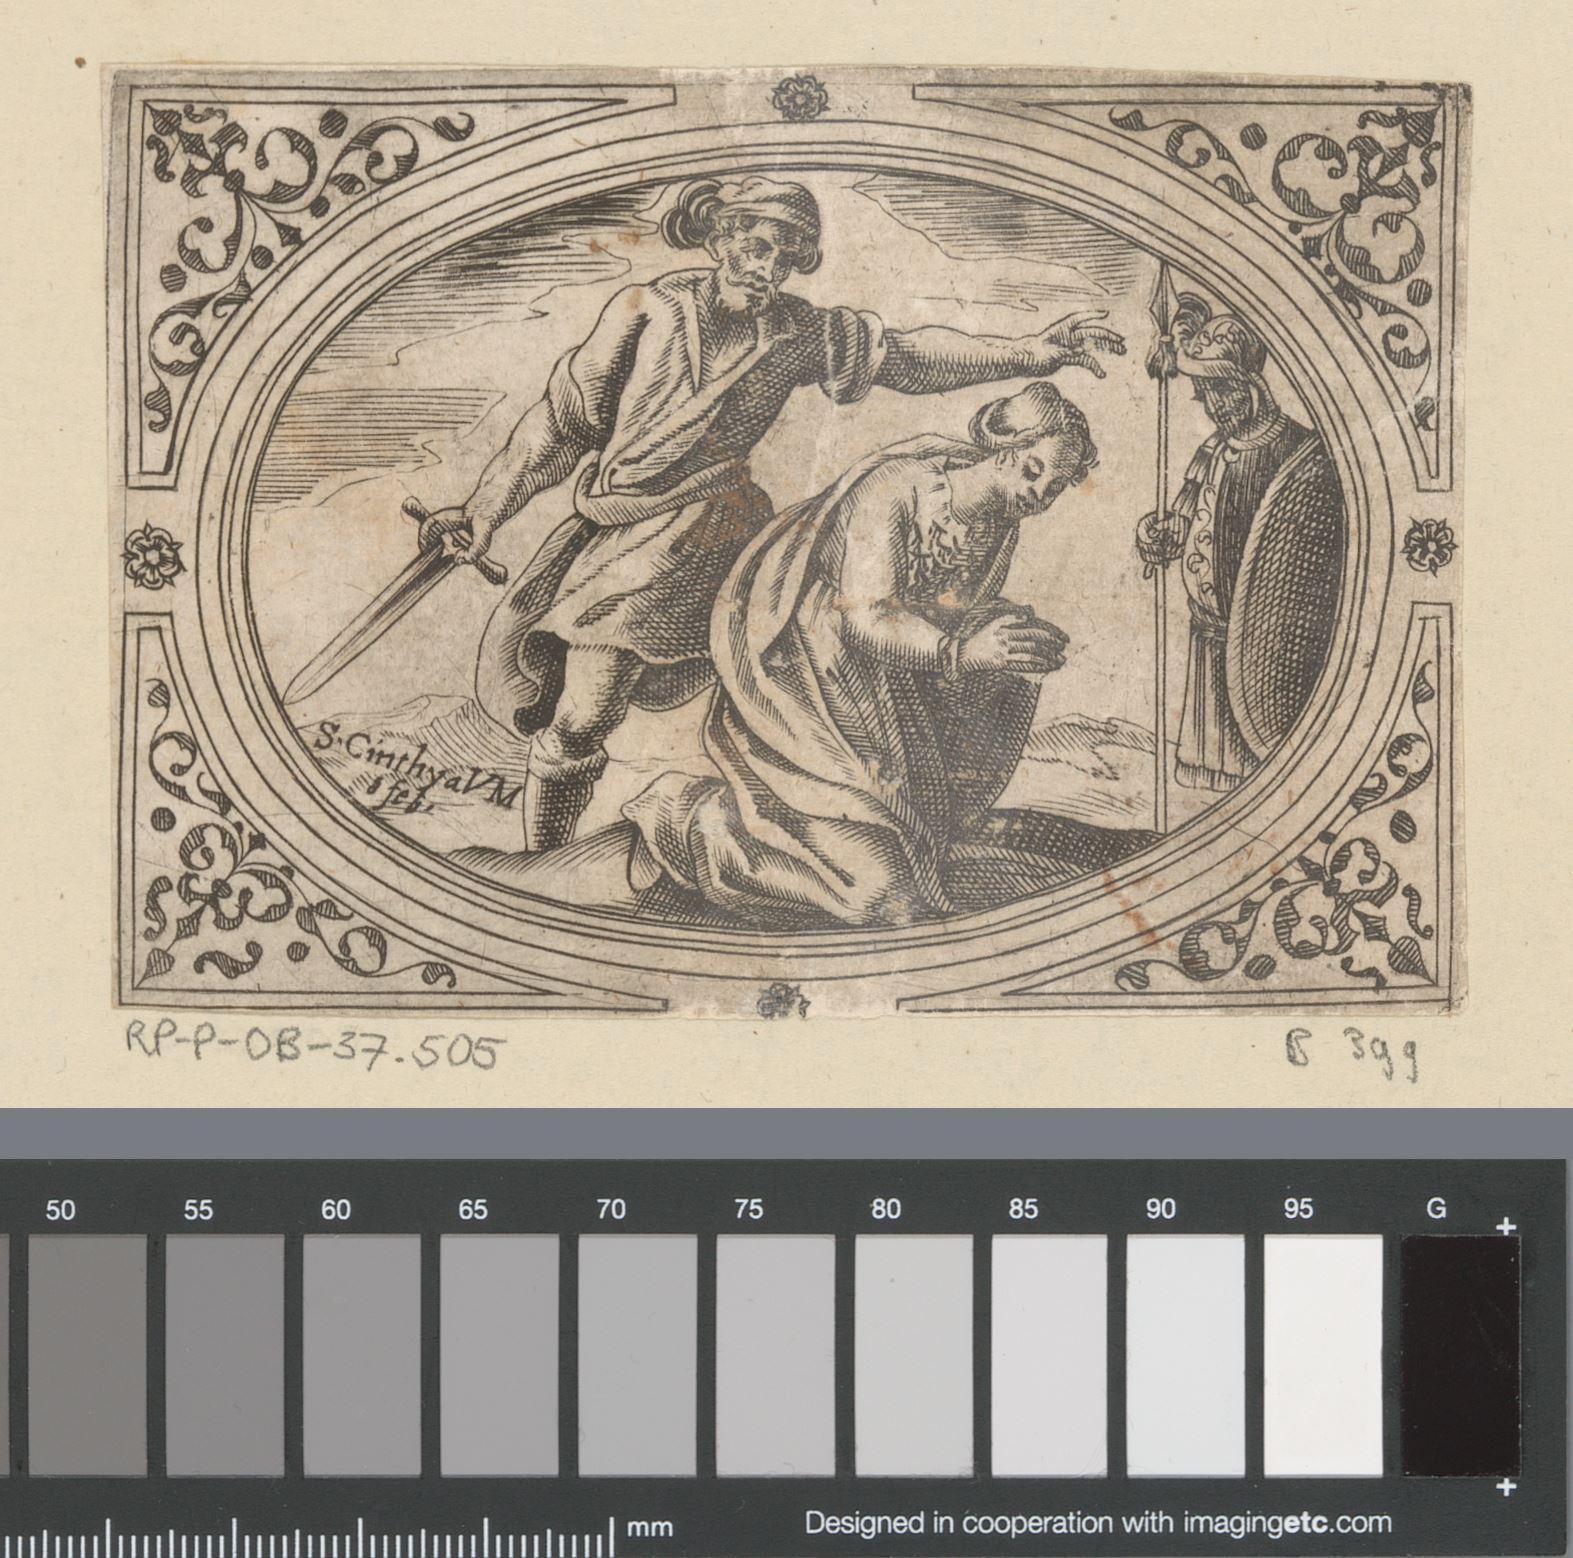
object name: print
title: H. Cynthia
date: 1565-1630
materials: paper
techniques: etching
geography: vatican city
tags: martyr(s) (often with palm-branches) - qq - female martyr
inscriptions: collector's mark: Lugt 240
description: Deze prent maakt deel uit van een reeks van 73 prenten (+ titelprent) met voorstellingen van Romeinse martelaressen.